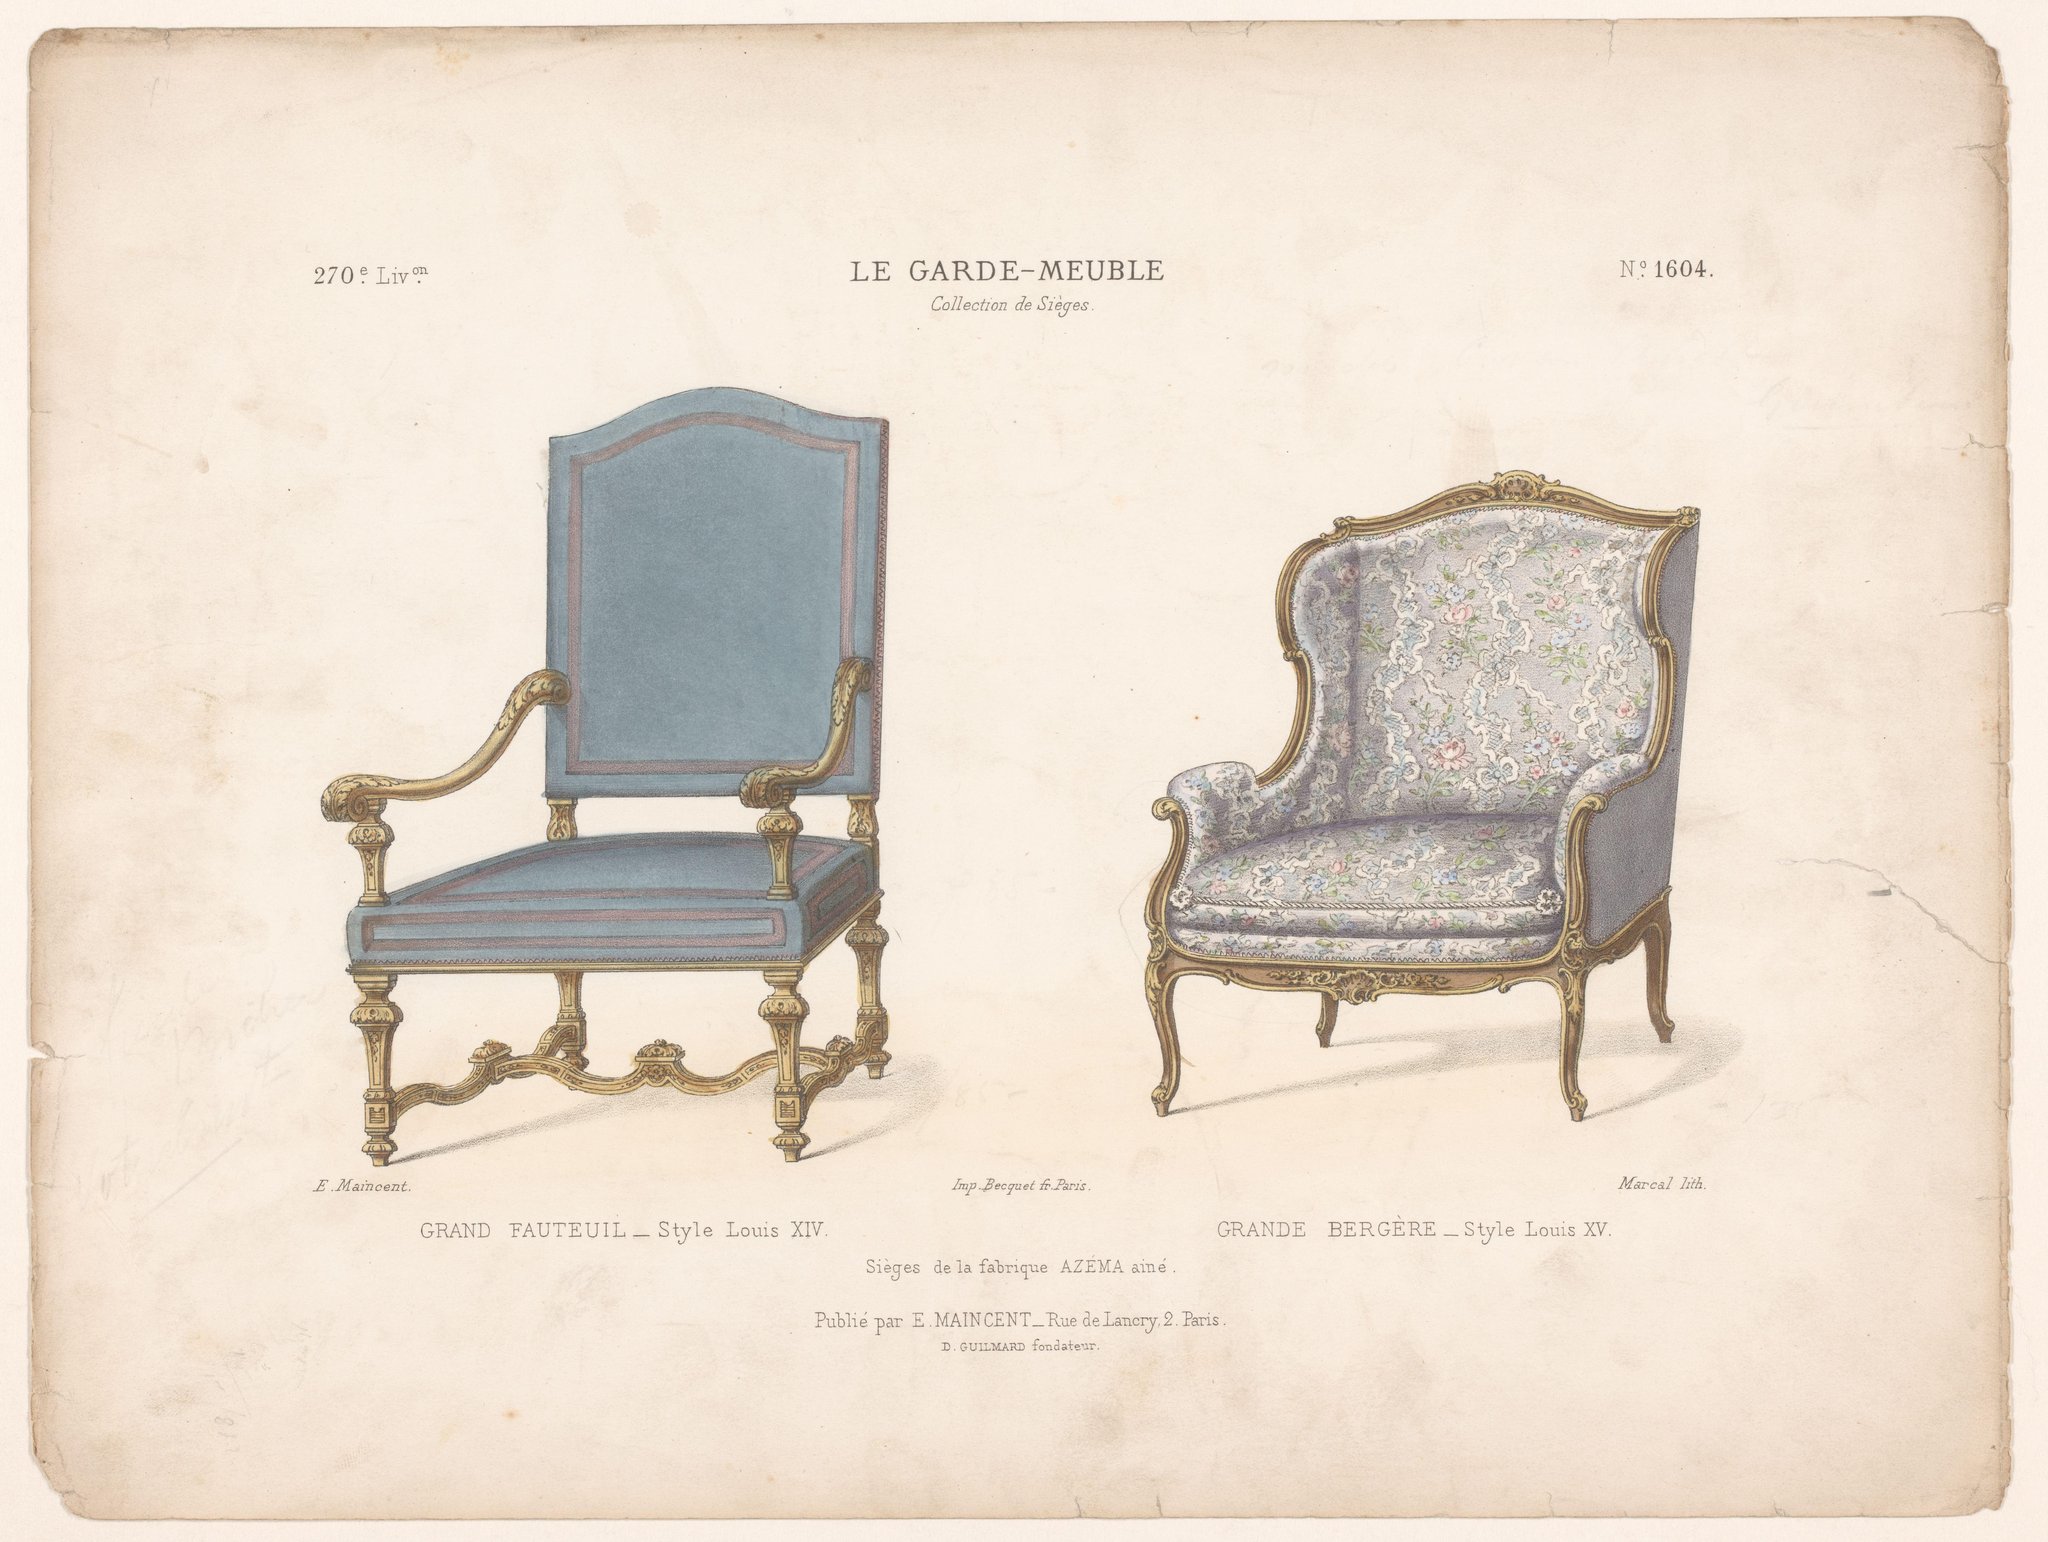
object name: print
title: Twee fauteuils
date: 1885-1895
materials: paper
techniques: hand coloring, lithograph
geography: paris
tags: seating furniture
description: Ieder Livraison in de serie Le Garde-Meuble bevat negen platen: drie 'sièges' (zitmeubels), drie 'meubles' (diverse meubels zoals tafels en kasten) en drie 'tentures' (gordijnen en draperieën).